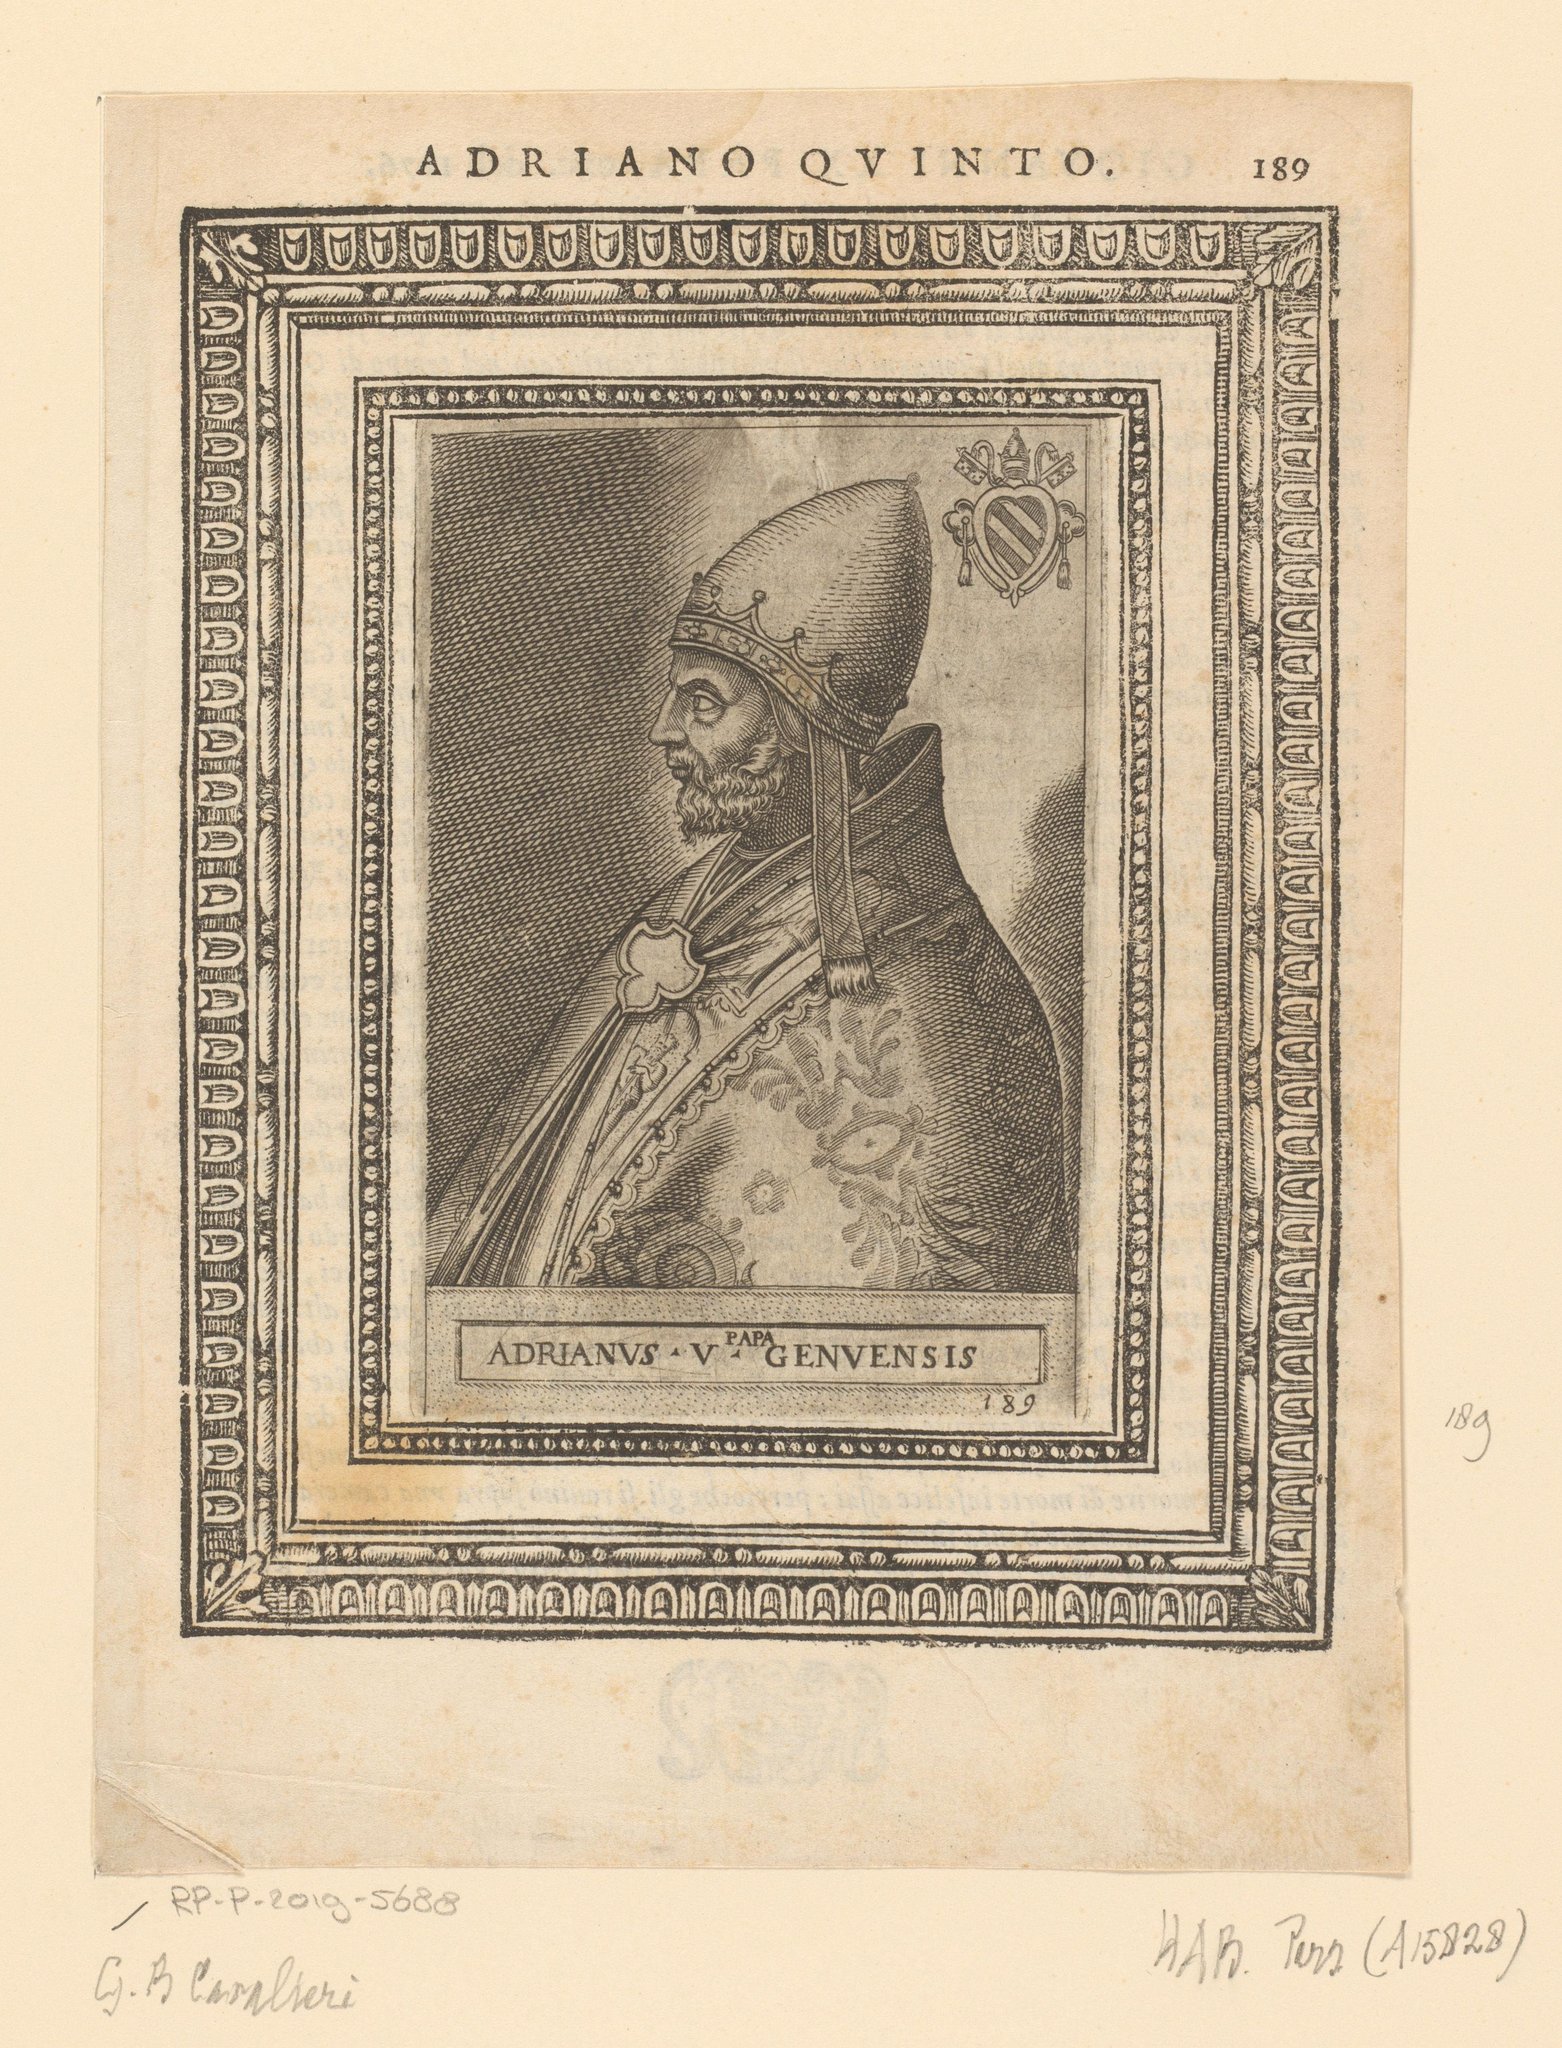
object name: print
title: Portret van paus Adrianus V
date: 1587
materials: paper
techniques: engraving, letterpress printing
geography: rome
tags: historical persons, pope, armorial bearing, heraldry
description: Prent uit: Ciccarelli, Antonio. Le vite de Pontefici di Antonio Ciccarelli (...). Rome: Domenico Basa, 1587. Prent voor het eerst verschenen in: Cavalieri, Giovanni Battista de'. Pontificum romanorum effigies (...). Rome: Domenico Basa en Francesco Zanetti, 1580. Prent ook gebruikt in latere publicaties.